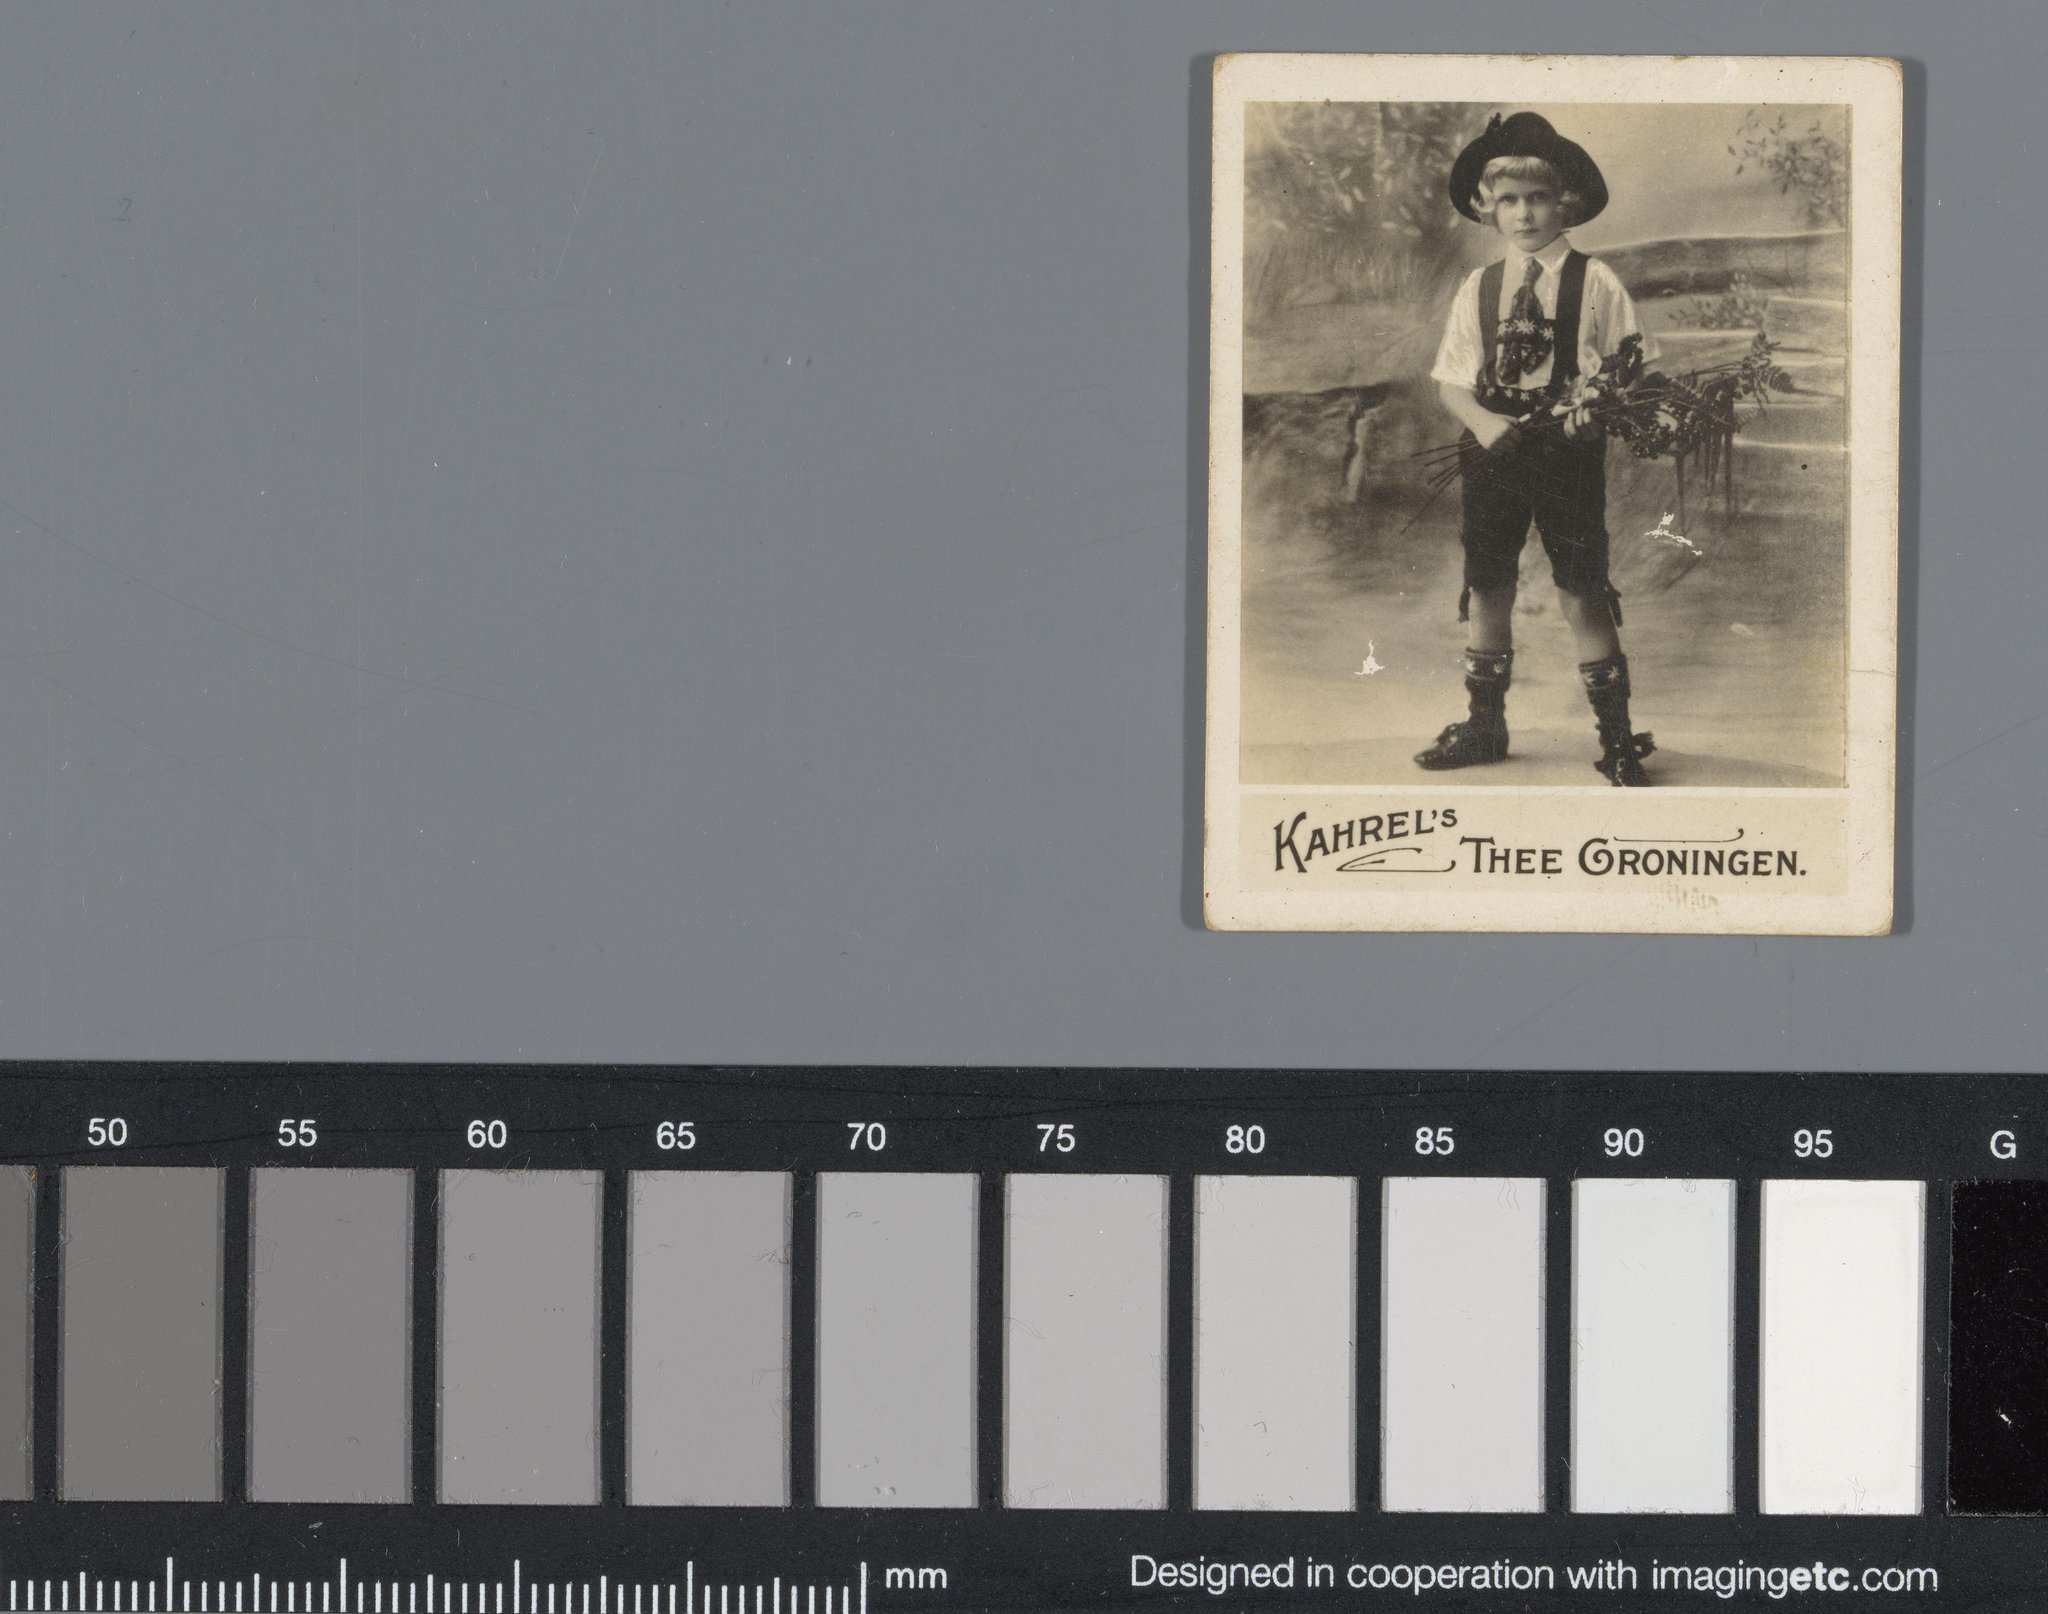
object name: photograph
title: Onbekende jongen met boeket in zijn handen, reclame voor Kahrel's Thee Groningen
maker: Anonymous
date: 1895-1910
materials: paper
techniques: gelatin silver print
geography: groningen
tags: boy (child between toddler and youth)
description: Dergelijke foto's stonden bekend als 'zwartjes'. Men verkreeg ze bij aanschaf van bepaalde merken thee, cacao, sigaretten, beschuit, etc. om te verzamelen. Er waren speciaal voor de 'zwartjes' verzamelalbums in omloop.